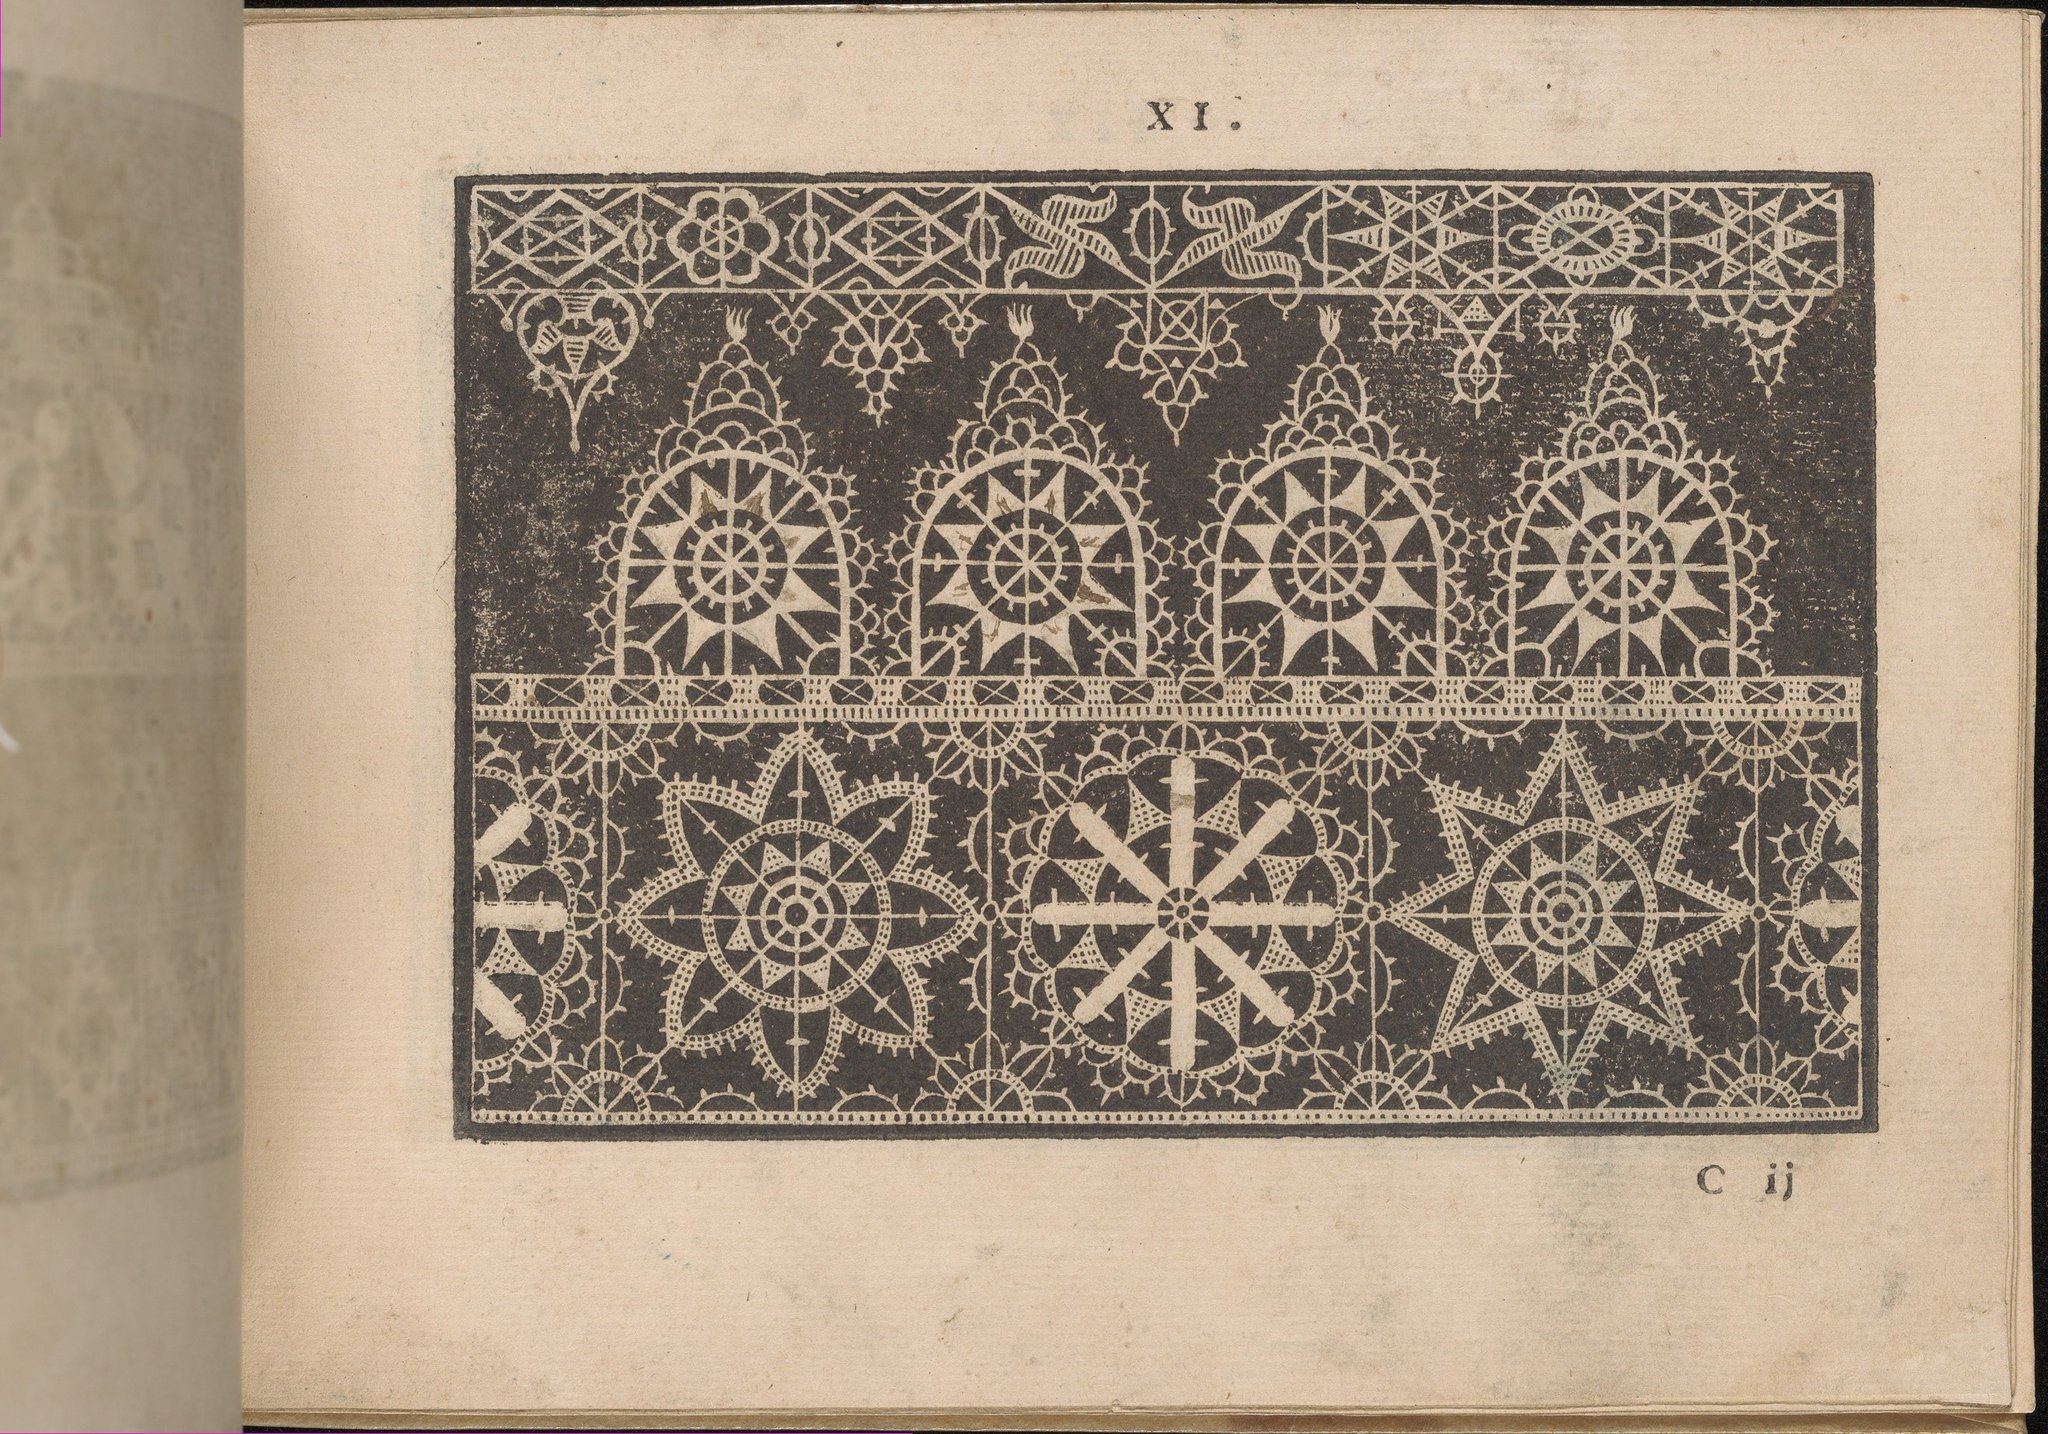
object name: book print ornament architecture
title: Prima Parte de' Fiori, e Disegni di varie sorti di Ricami Moderni, page 11 (recto)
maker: giovanni battista ciotti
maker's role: author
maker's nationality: italian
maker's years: 1555-1659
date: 1591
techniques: woodcut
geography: italy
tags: stars,flowers